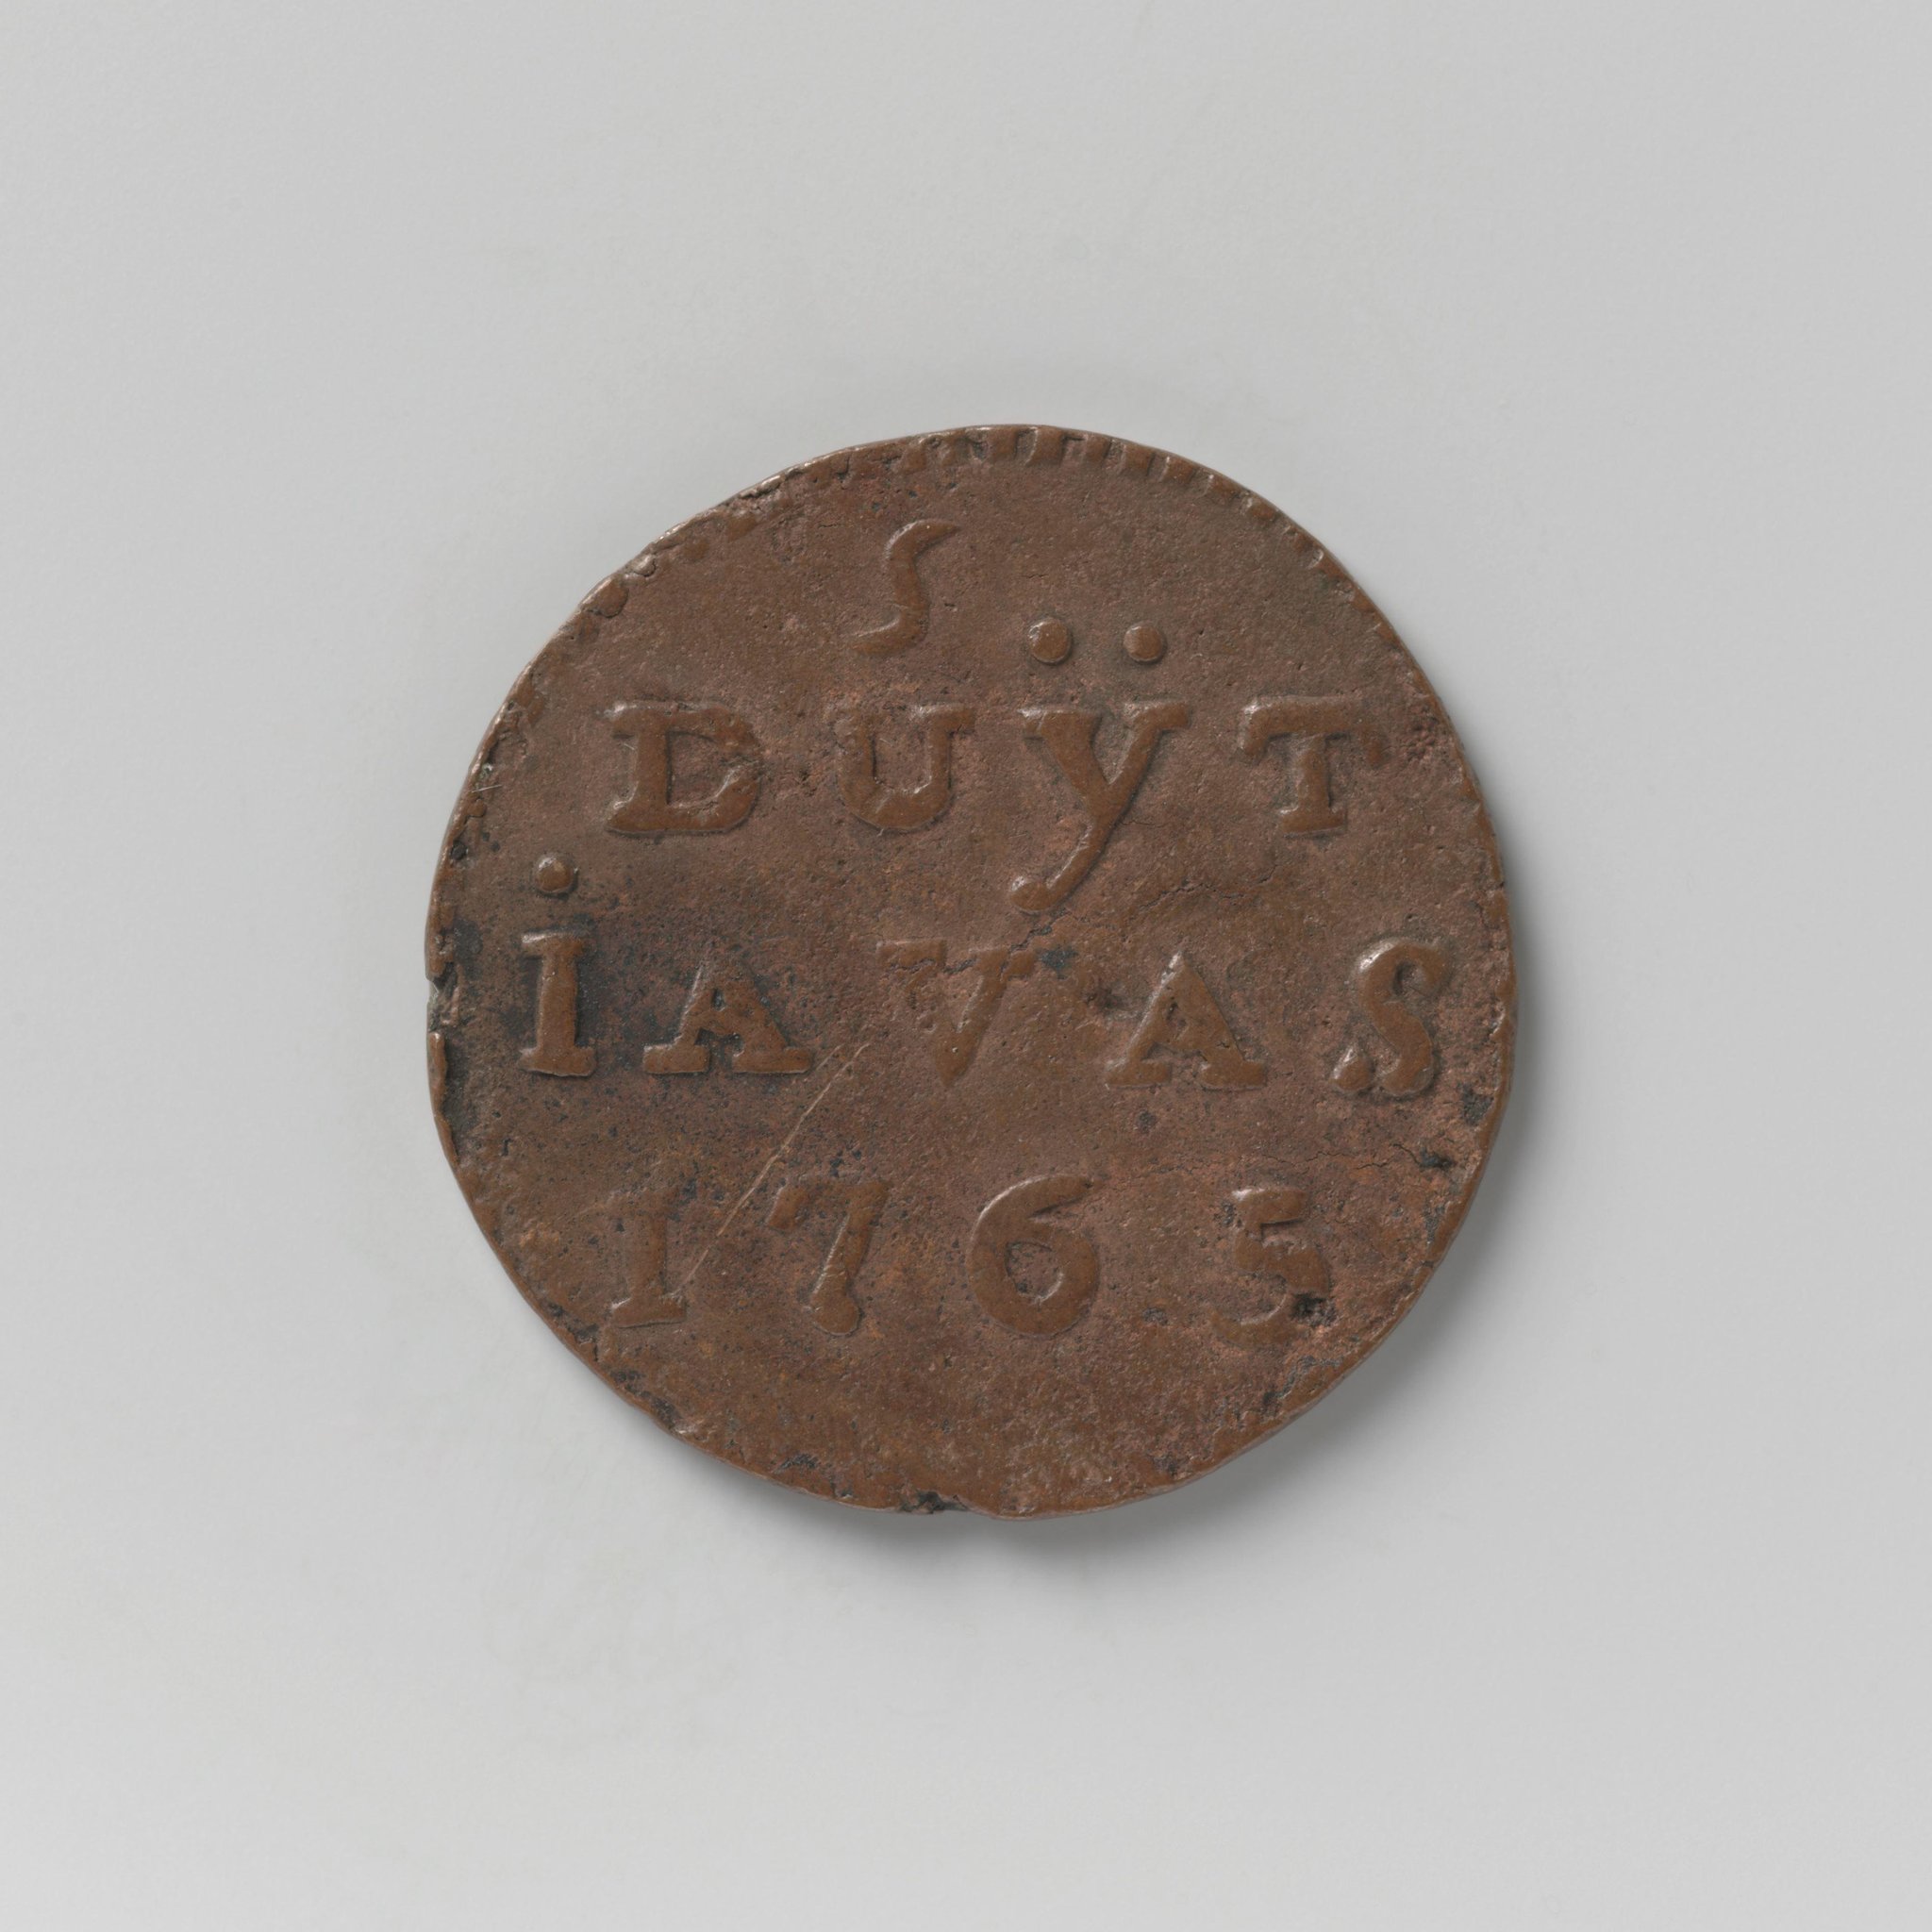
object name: coin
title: Duit van de VOC uit Java,1765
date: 1765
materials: copper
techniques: striking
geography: batavia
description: Koperen munt. Voorzijde: tweeregelig opschrift in Latijnse letters. Daaronder jaartal in aangepaste Arabische cijfers. Keerzijde: Eensluidend tweeregelig opschrift in Arabische letters. Daaronder jaartal in oorspronkelijke Arabische cijfers. Gladde rand.